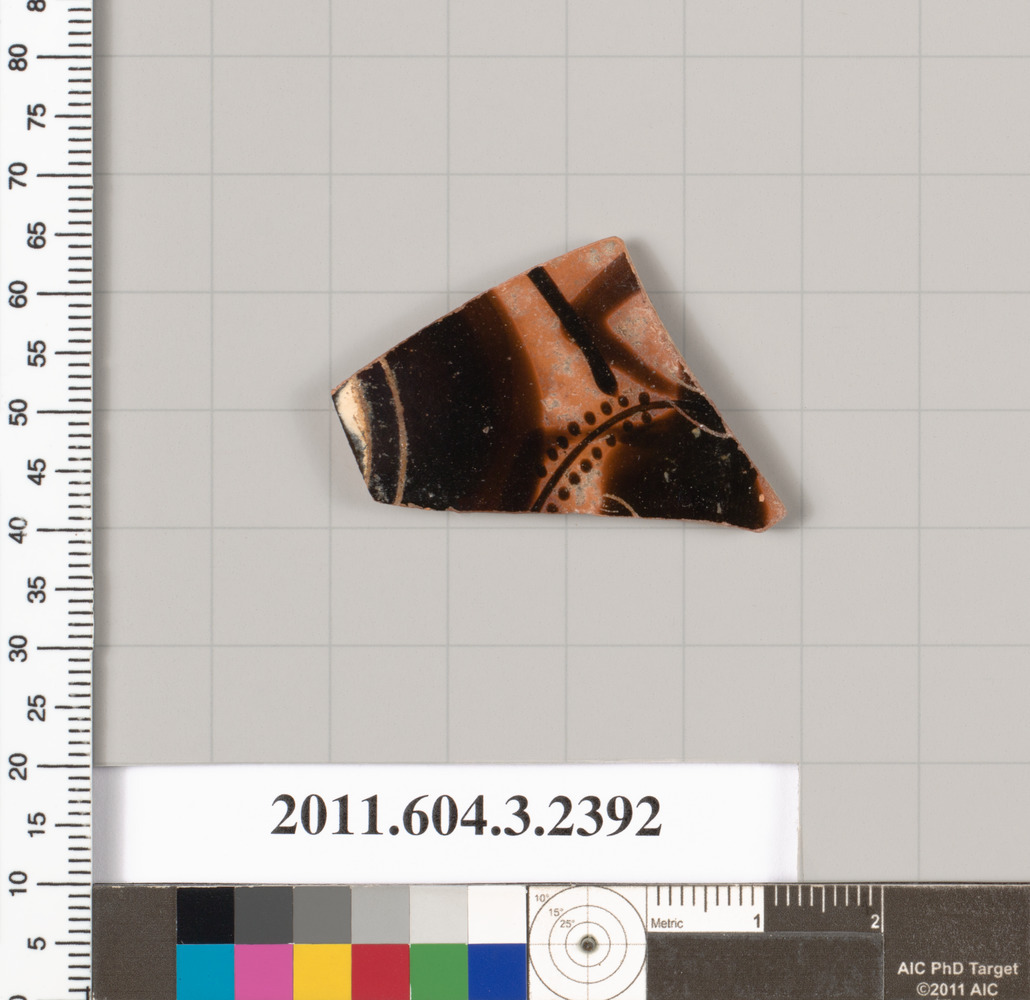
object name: kylix fragment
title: Terracotta fragment of a kylix: eye-cup (drinking cup)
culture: greek, attic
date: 525-501 BCE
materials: terracotta